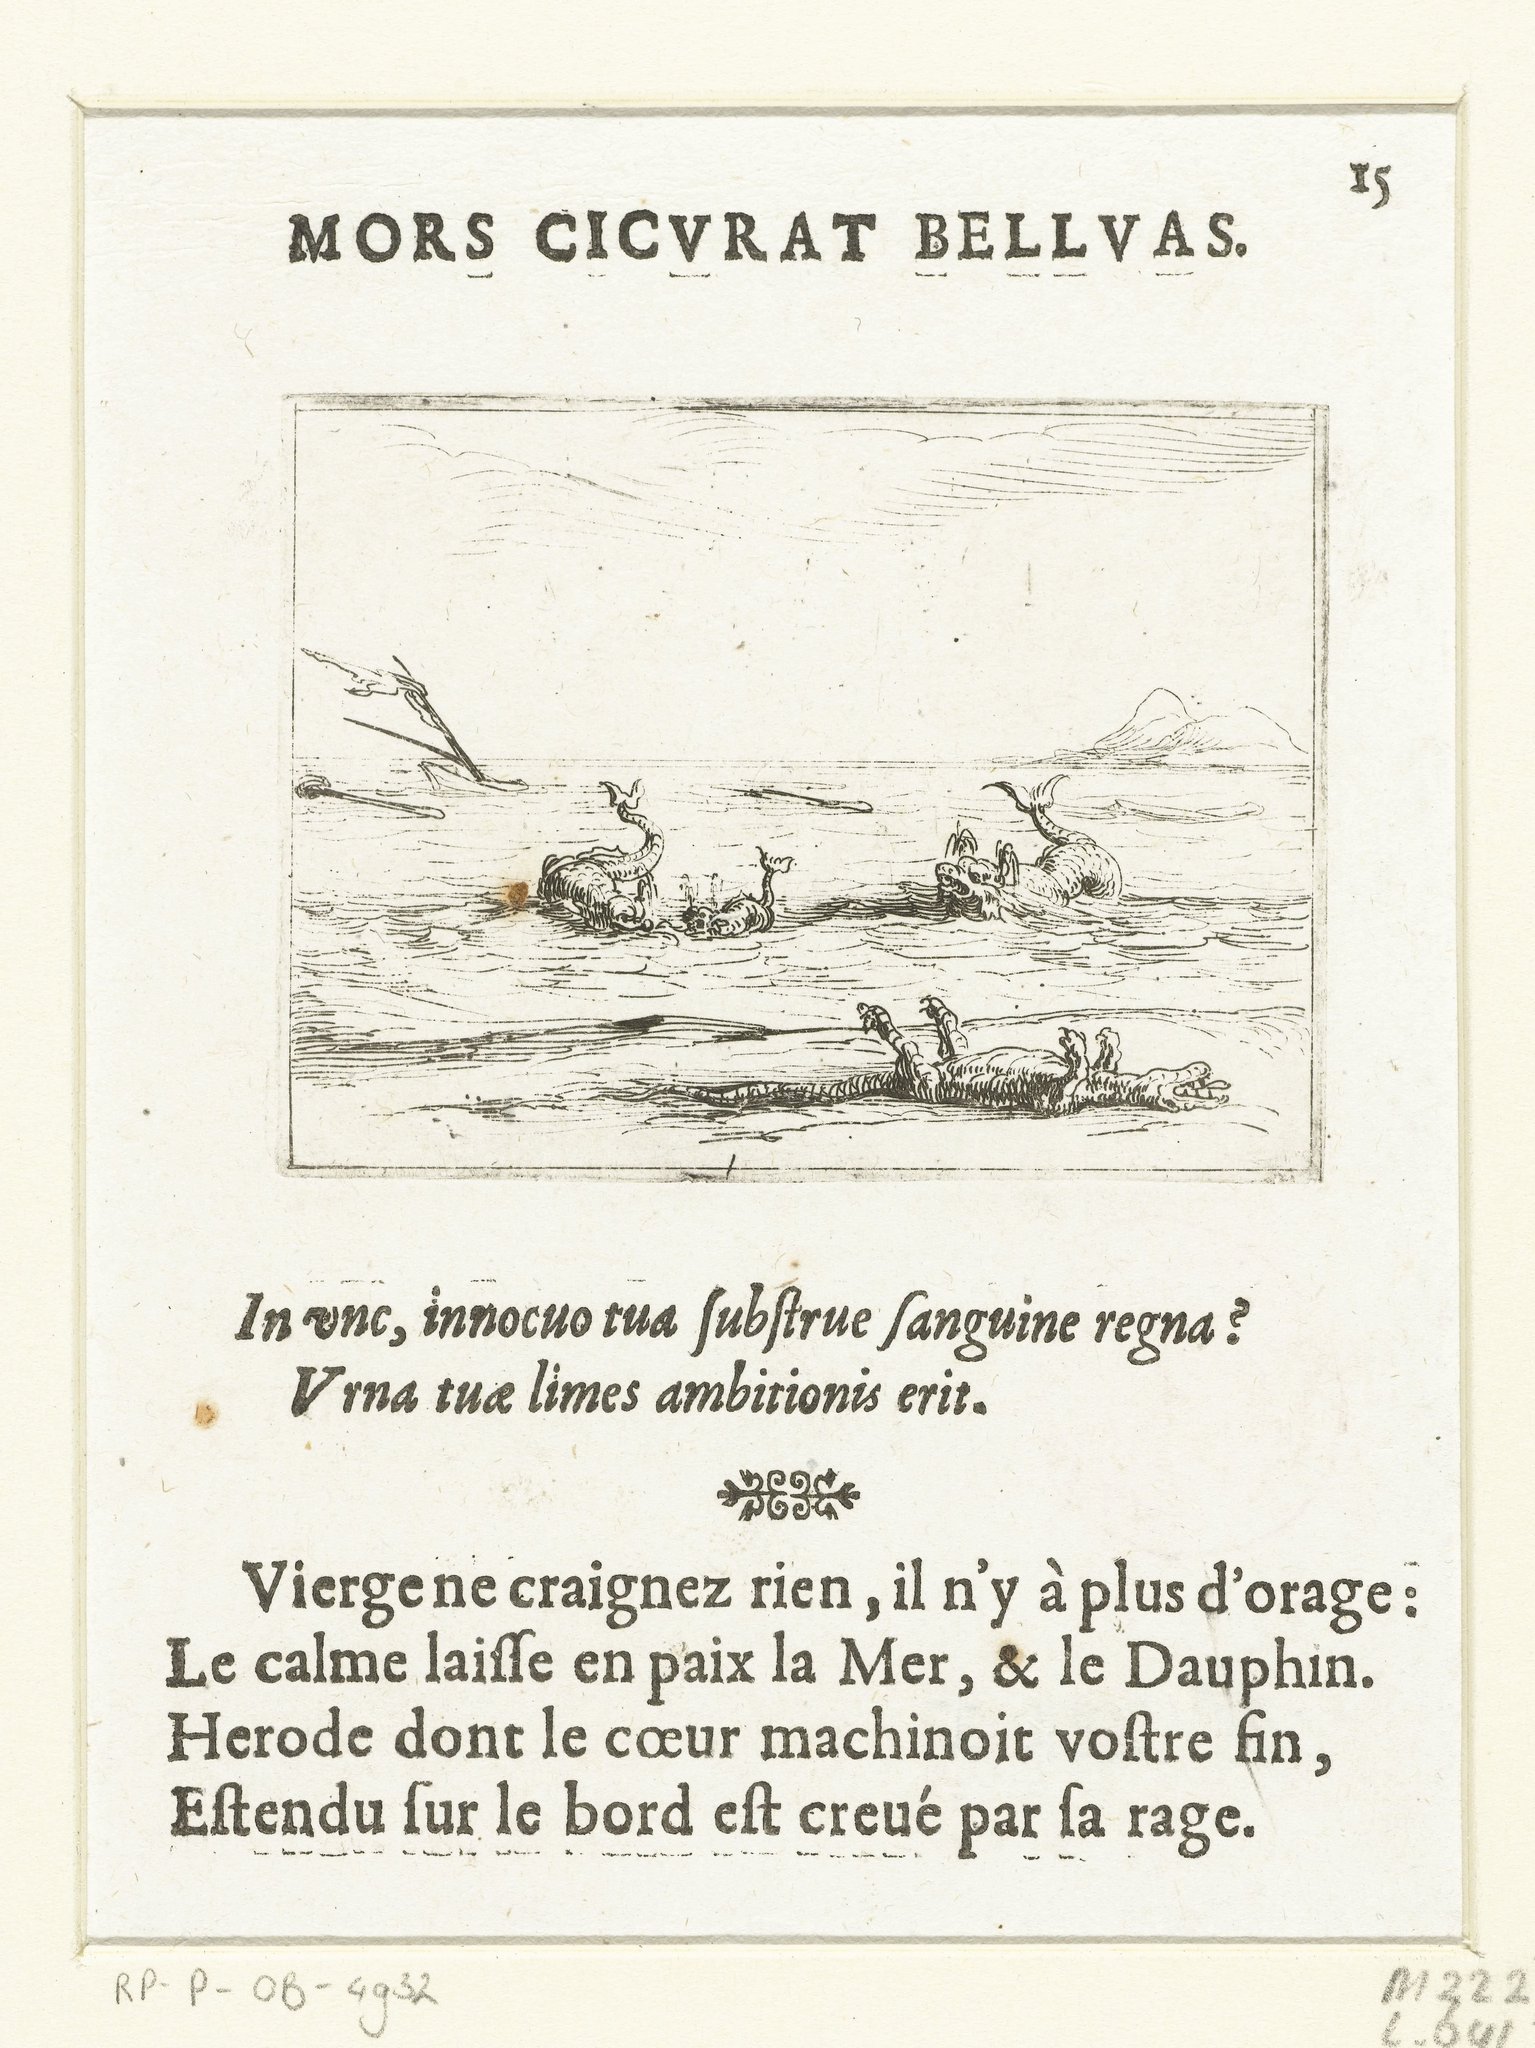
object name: print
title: Drie dolfijnen en een dode krokodil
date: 1625-1629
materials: paper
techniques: etching, letterpress printing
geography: nancy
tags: crocodiles, swimming mammals: dolphin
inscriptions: collector's mark: Lugt 240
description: Voorstelling van twee volwassen dolfijnen en een babydolfijn, die zwemmen in de buurt van een strand waarop een dode krokodil ligt. Boven en onder deze prent Latijnse en Franse teksten in boekdruk. Dit blad is onderdeel van de embleemserie 'Leven van Maria in emblemen'. De eerste staat van deze serie behelst naast een titelpagina en 26 emblemen ook drie bladen met lofzangen op Maria in boekdruk zonder afbeelding.